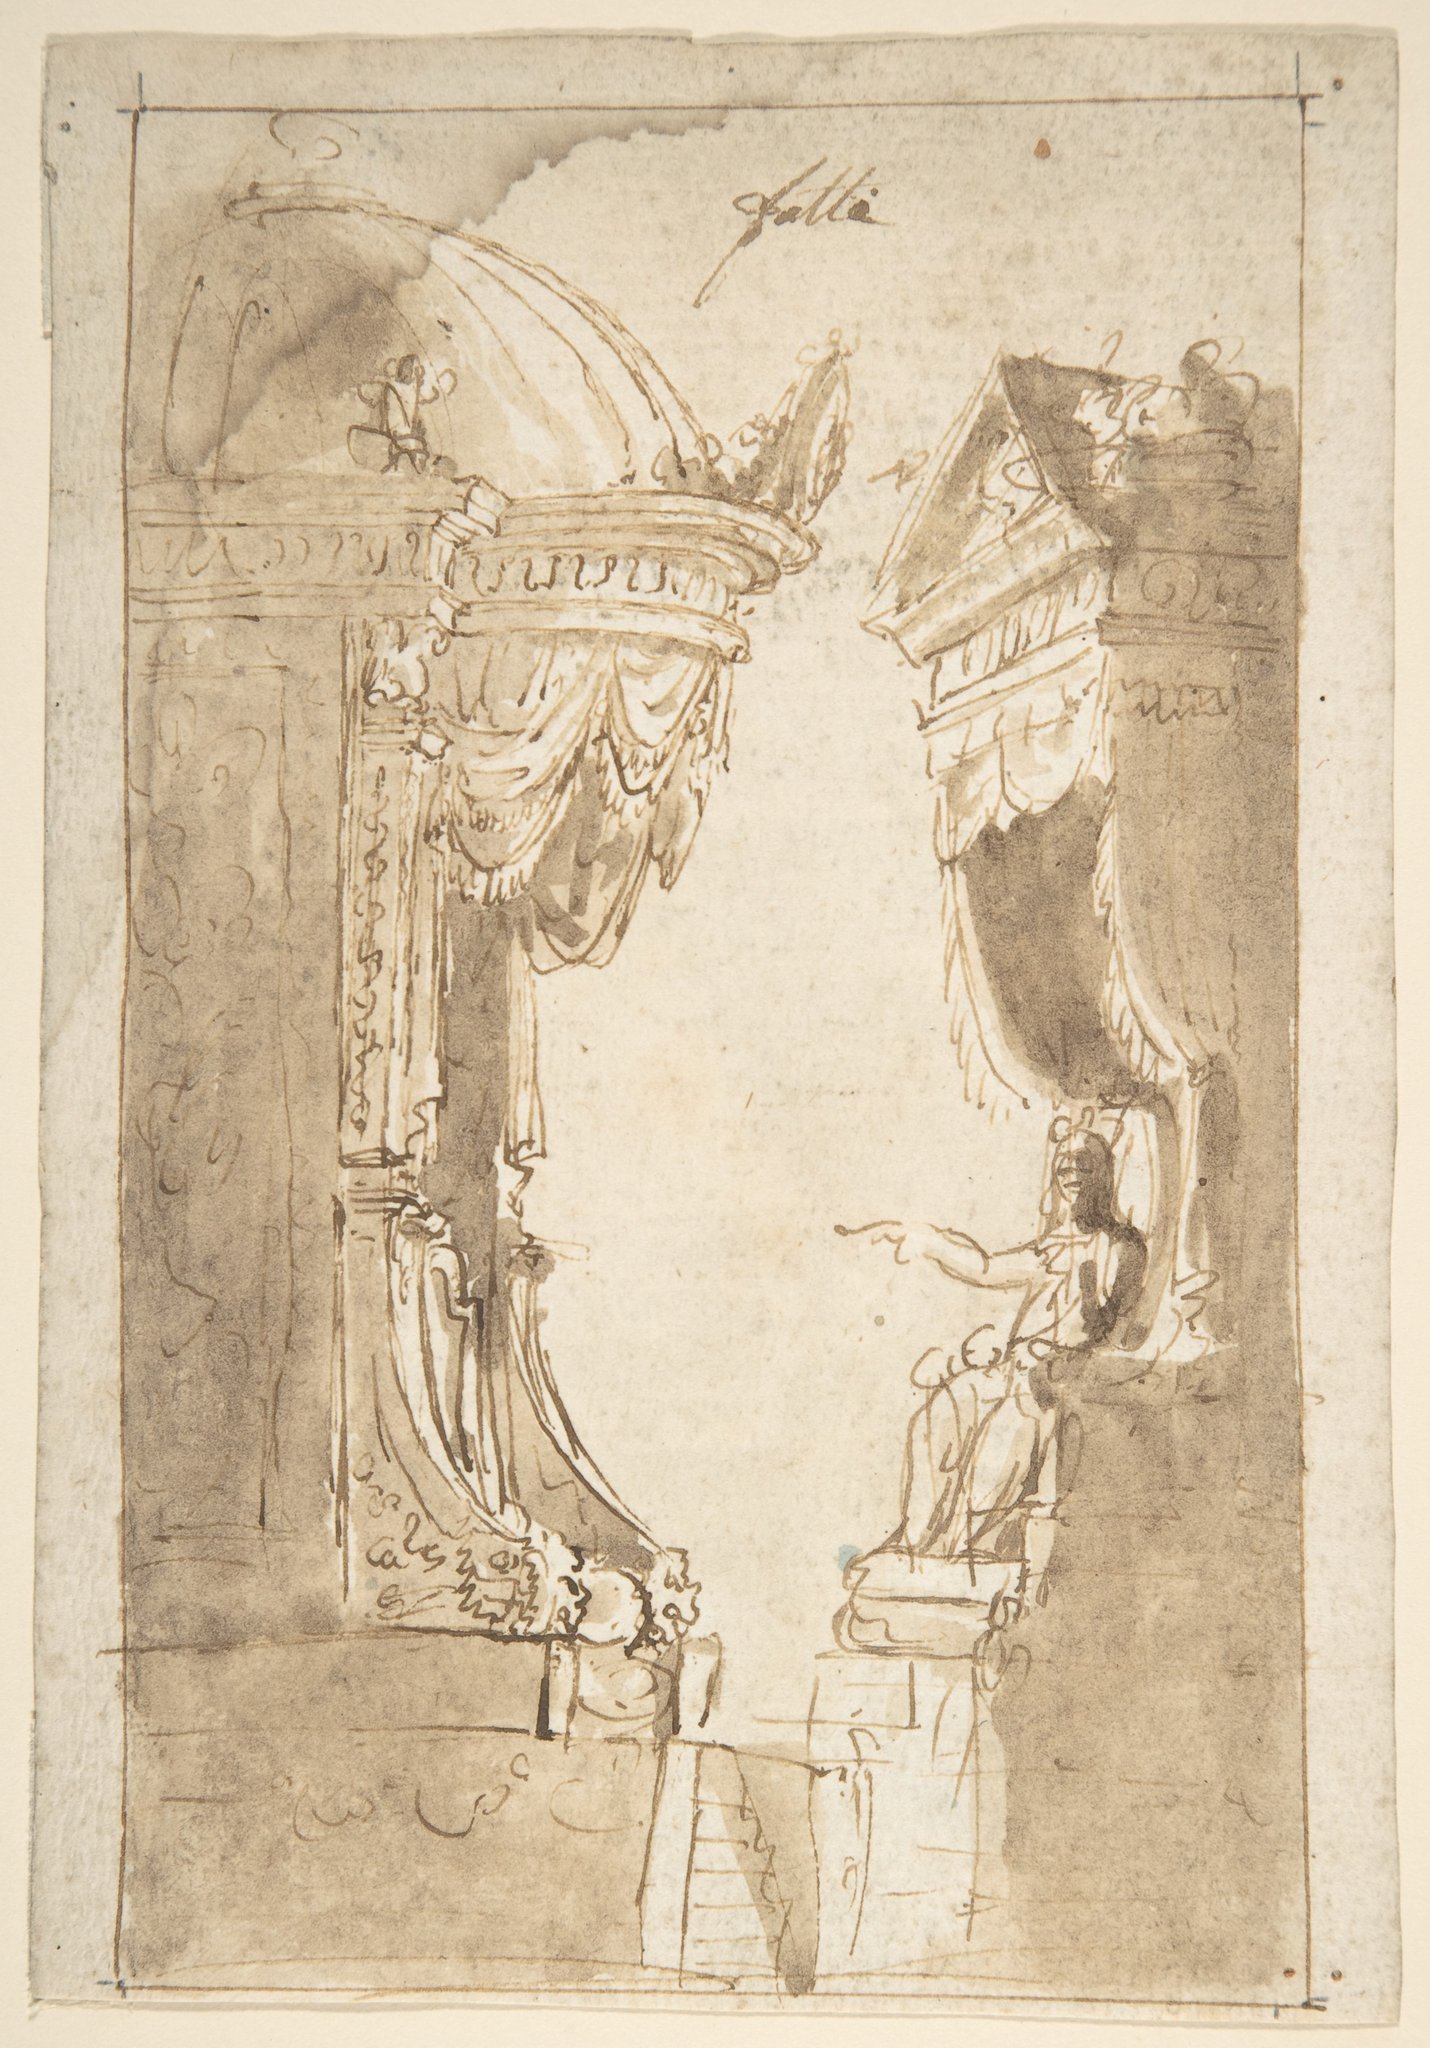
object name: drawing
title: Design for a Stage Set with Two Thrones (recto); Landscape (verso)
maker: anonymous, italian, 19th century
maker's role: artist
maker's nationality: italian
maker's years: 1800-1900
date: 1800-1900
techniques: pen, wash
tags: thrones,stage design